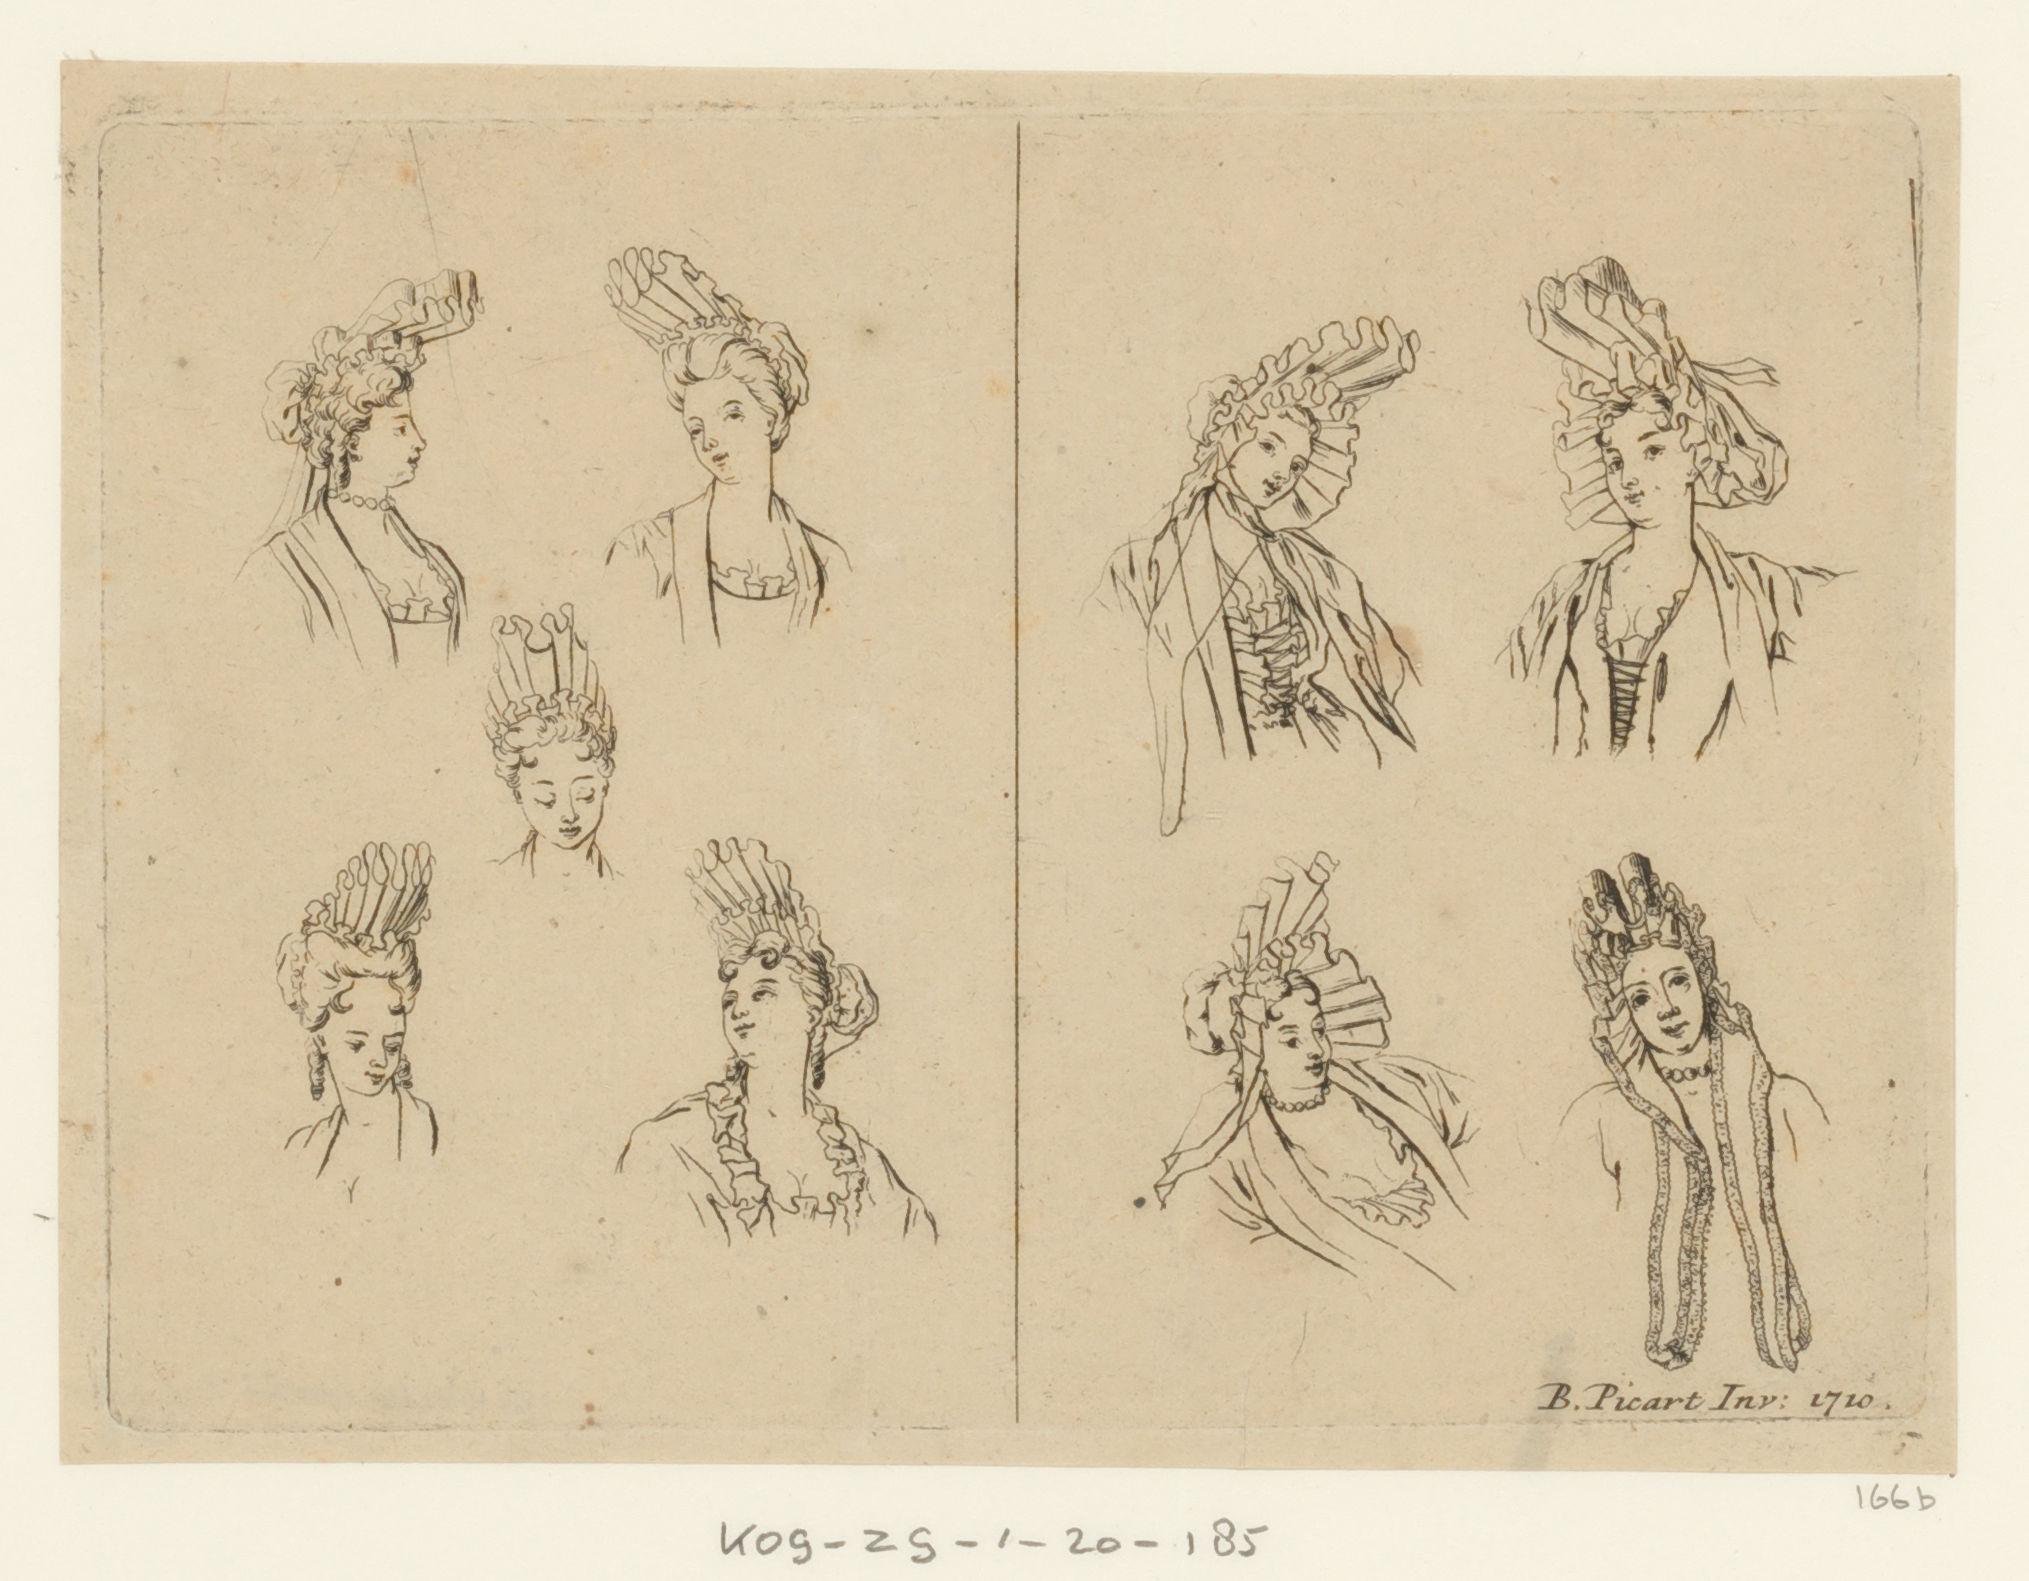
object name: print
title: Negen vrouwenhoofden die verschillende manieren tonen om een hoed te dragen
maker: bernard picart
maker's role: draughtsman, print maker, publisher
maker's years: 1673-1733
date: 1710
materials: paper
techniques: etching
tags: head (human), styles of hairdress (with name) - aa - ~ women, head-gear: fontange (+ women's clothes)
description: Studieblad met negen vrouwen hoofden. Links en rechts hebben de vrouwen een andere hoofddeksels op. De vrouwen met hoofddeksel wordt van verschillende kanten getoond. Onderwerpsrubrieken binnen de Atlas Zeden en Gewoonten: Zeden en Gewoonten in Engeren Zin, De Kleeding, Kleederdrachten (tijdvakken), Lodewijk XIV (1650 – 1720). Het allonge tijdvak).